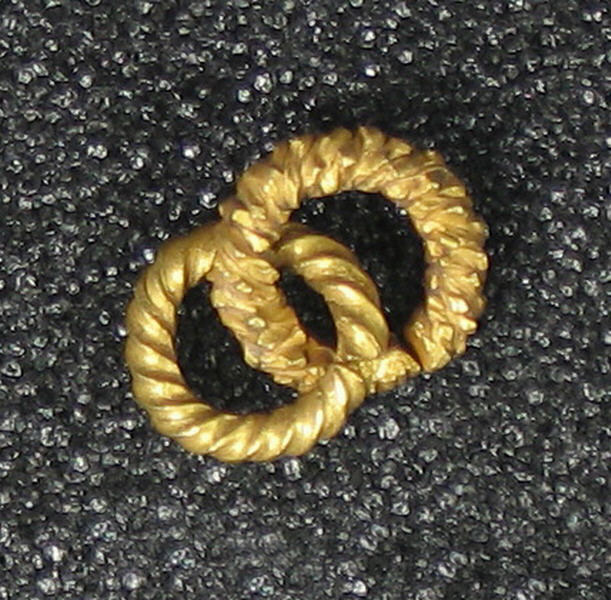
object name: earring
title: Earring with Wire and Granules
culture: indonesian, central java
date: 701-1200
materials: gold